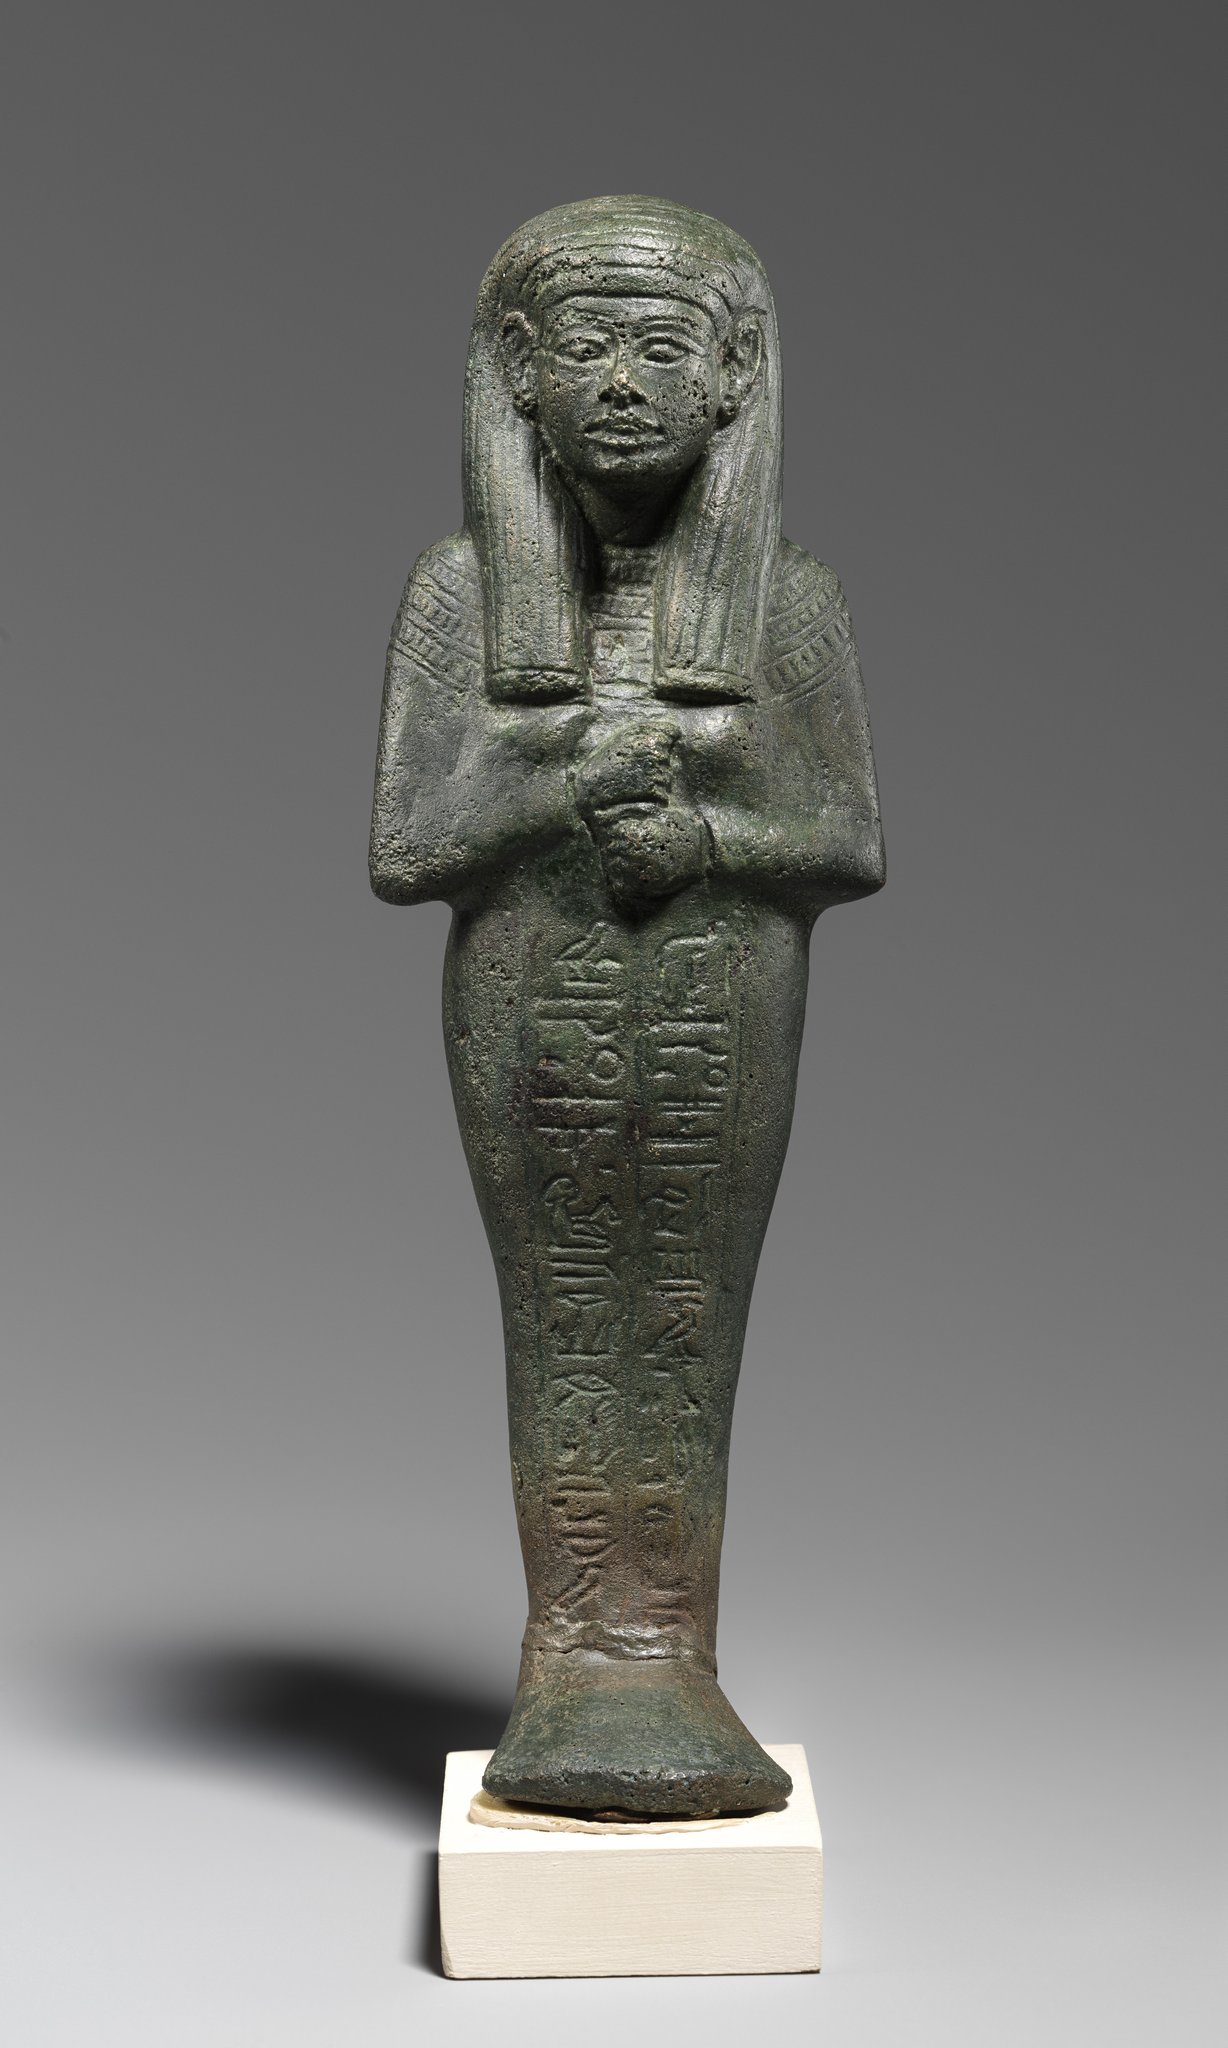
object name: shabti, nakhtmin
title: Shabti of Nakhtmin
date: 1550-1295 BCE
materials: bronze, copper alloy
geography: egypt